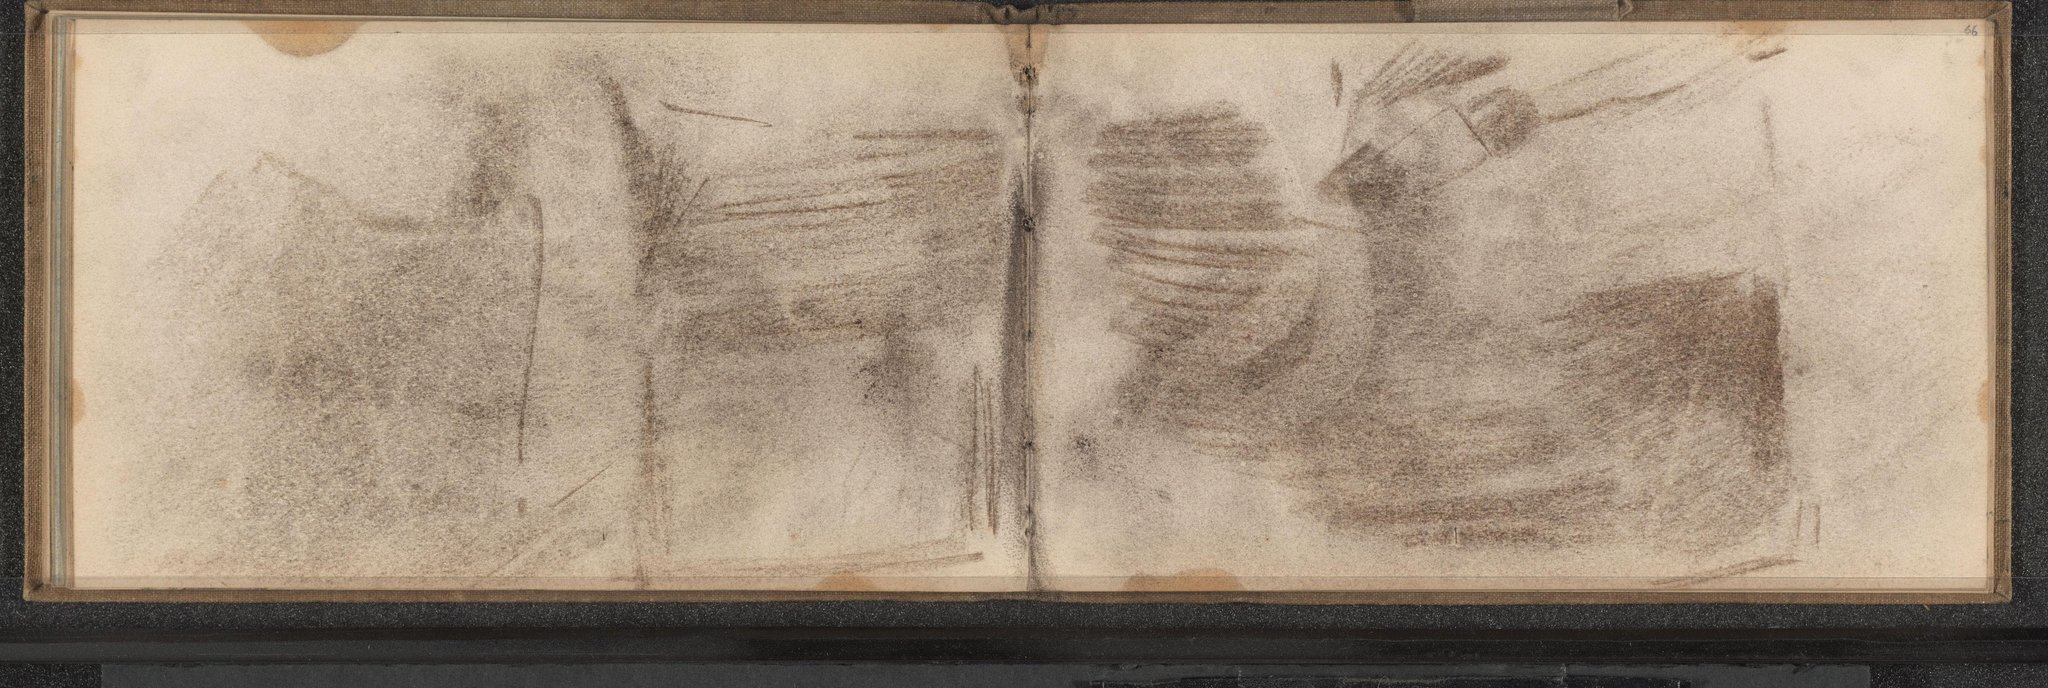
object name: sketchbook leaf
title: Studie, mogelijk van een interieur van een schuur of boerderij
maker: george hendrik breitner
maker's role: draughtsman, painter, print maker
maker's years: 1857-1923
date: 1883-1885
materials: chalk, paper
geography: drenthe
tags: barn - aa - civic architecture: inside, farm (building) - aa - civic architecture: inside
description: Pagina 65 en pagina 66 uit een schetsboek met 48 bladen.